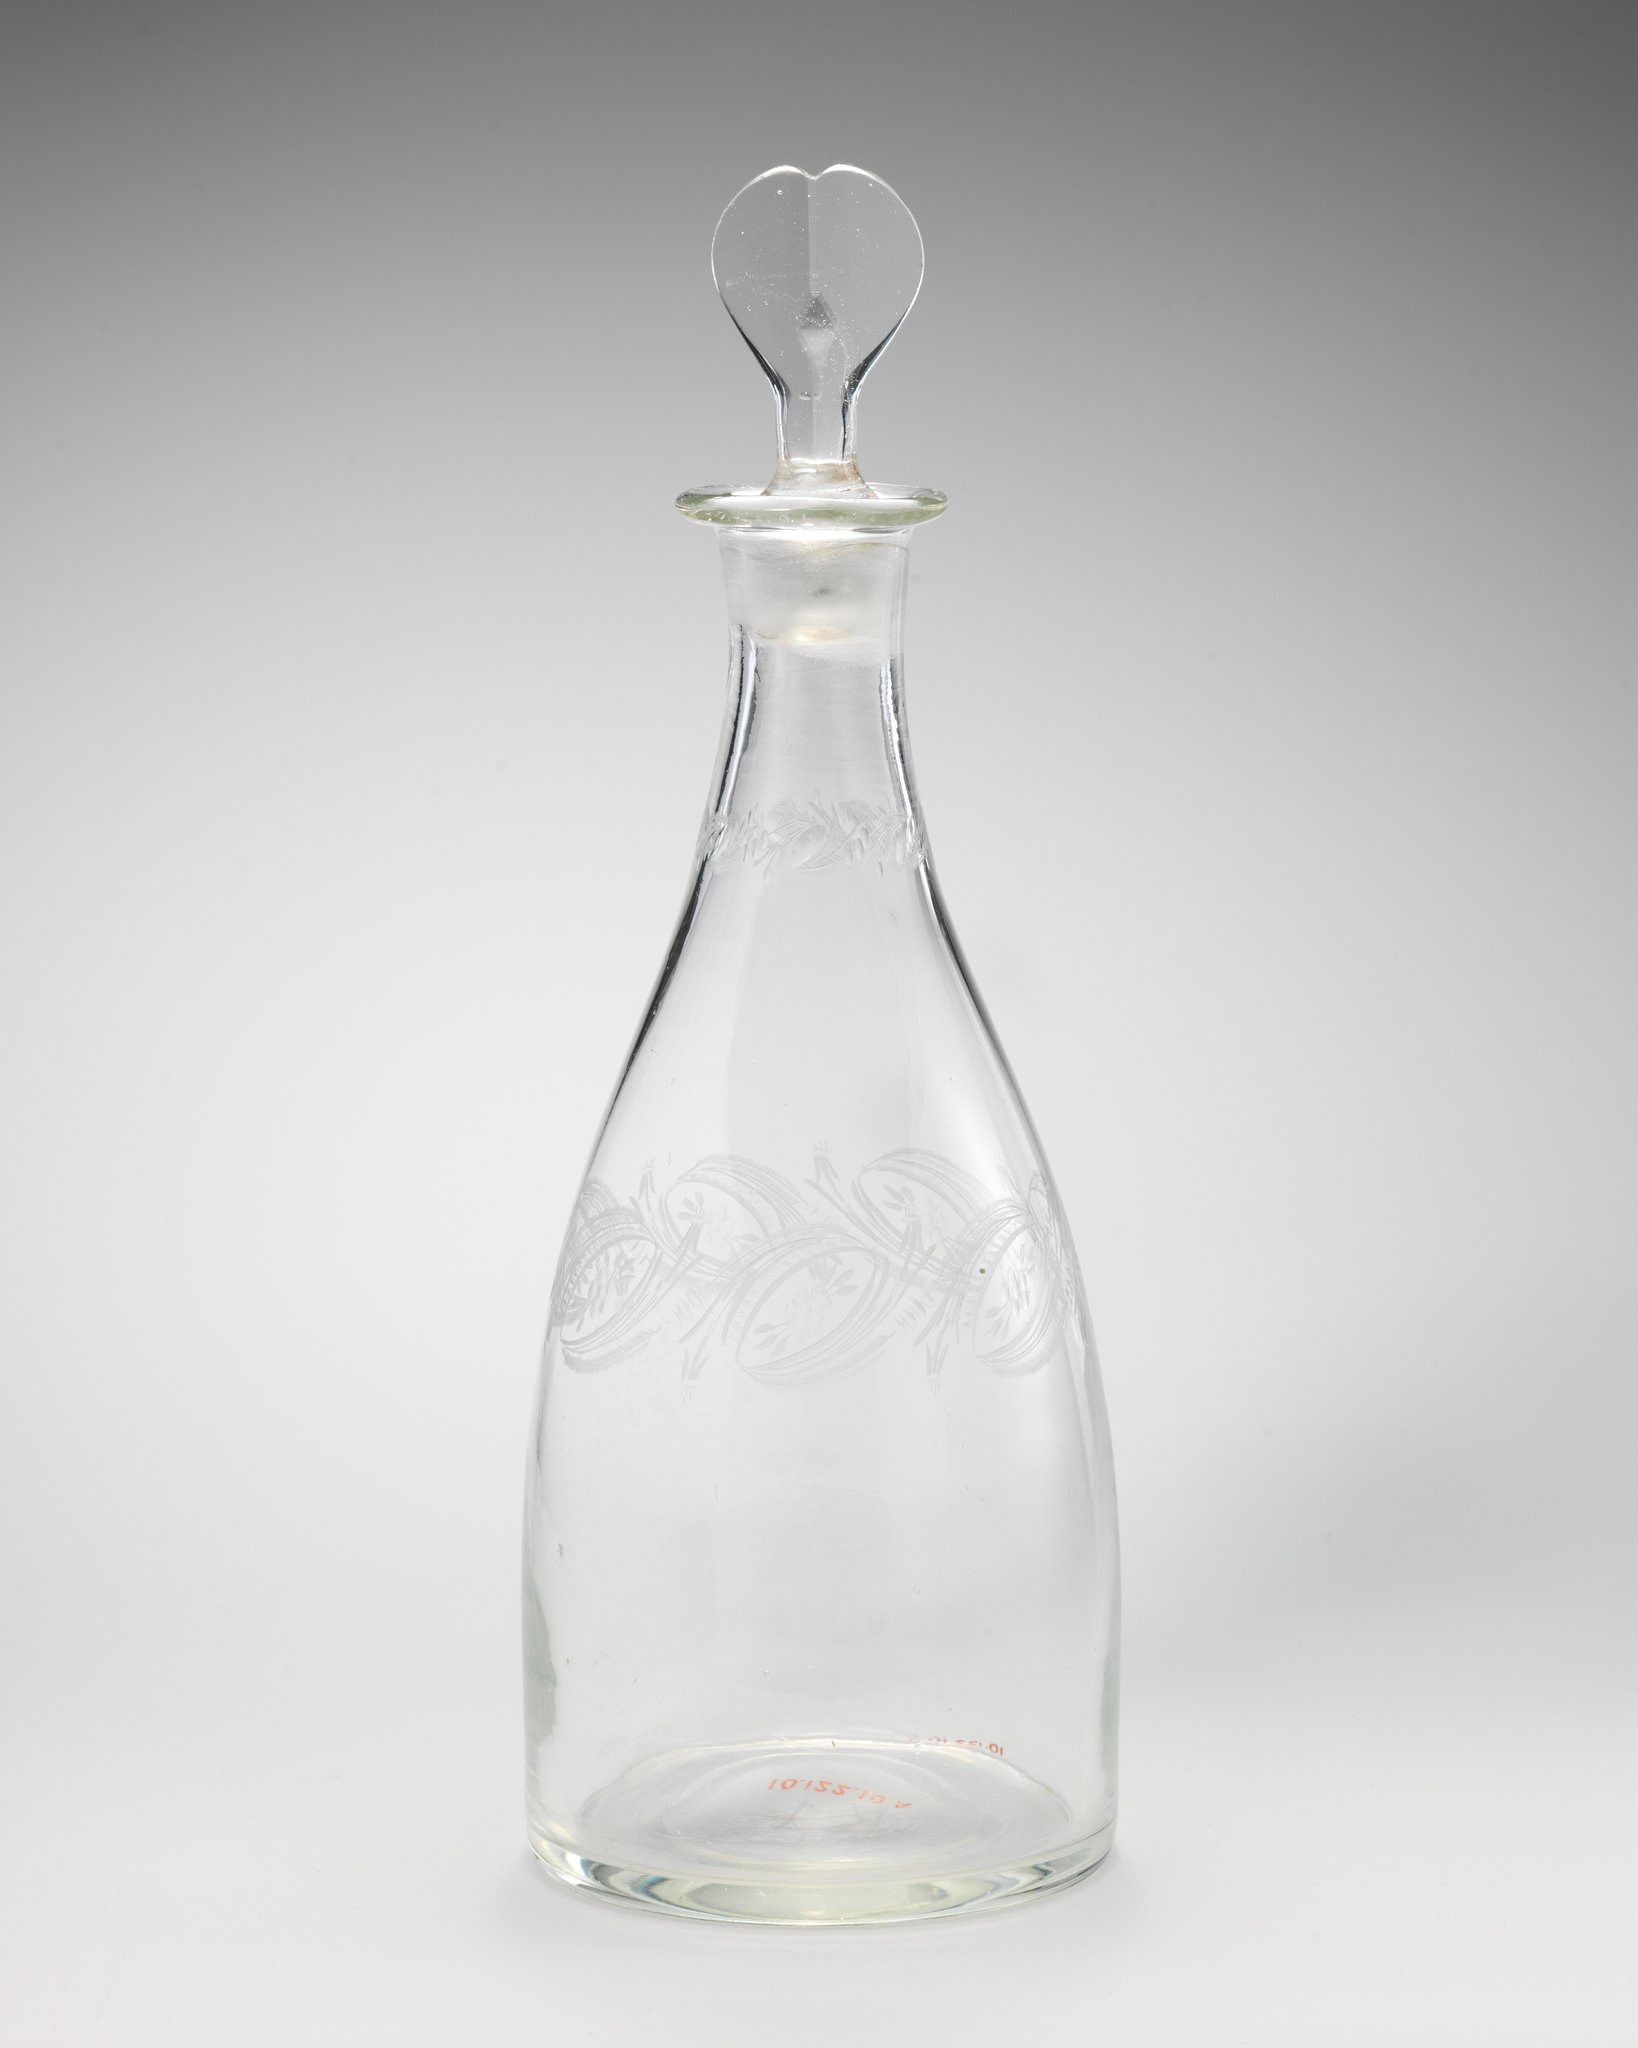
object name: decanter with stopper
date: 1767-1800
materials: glass